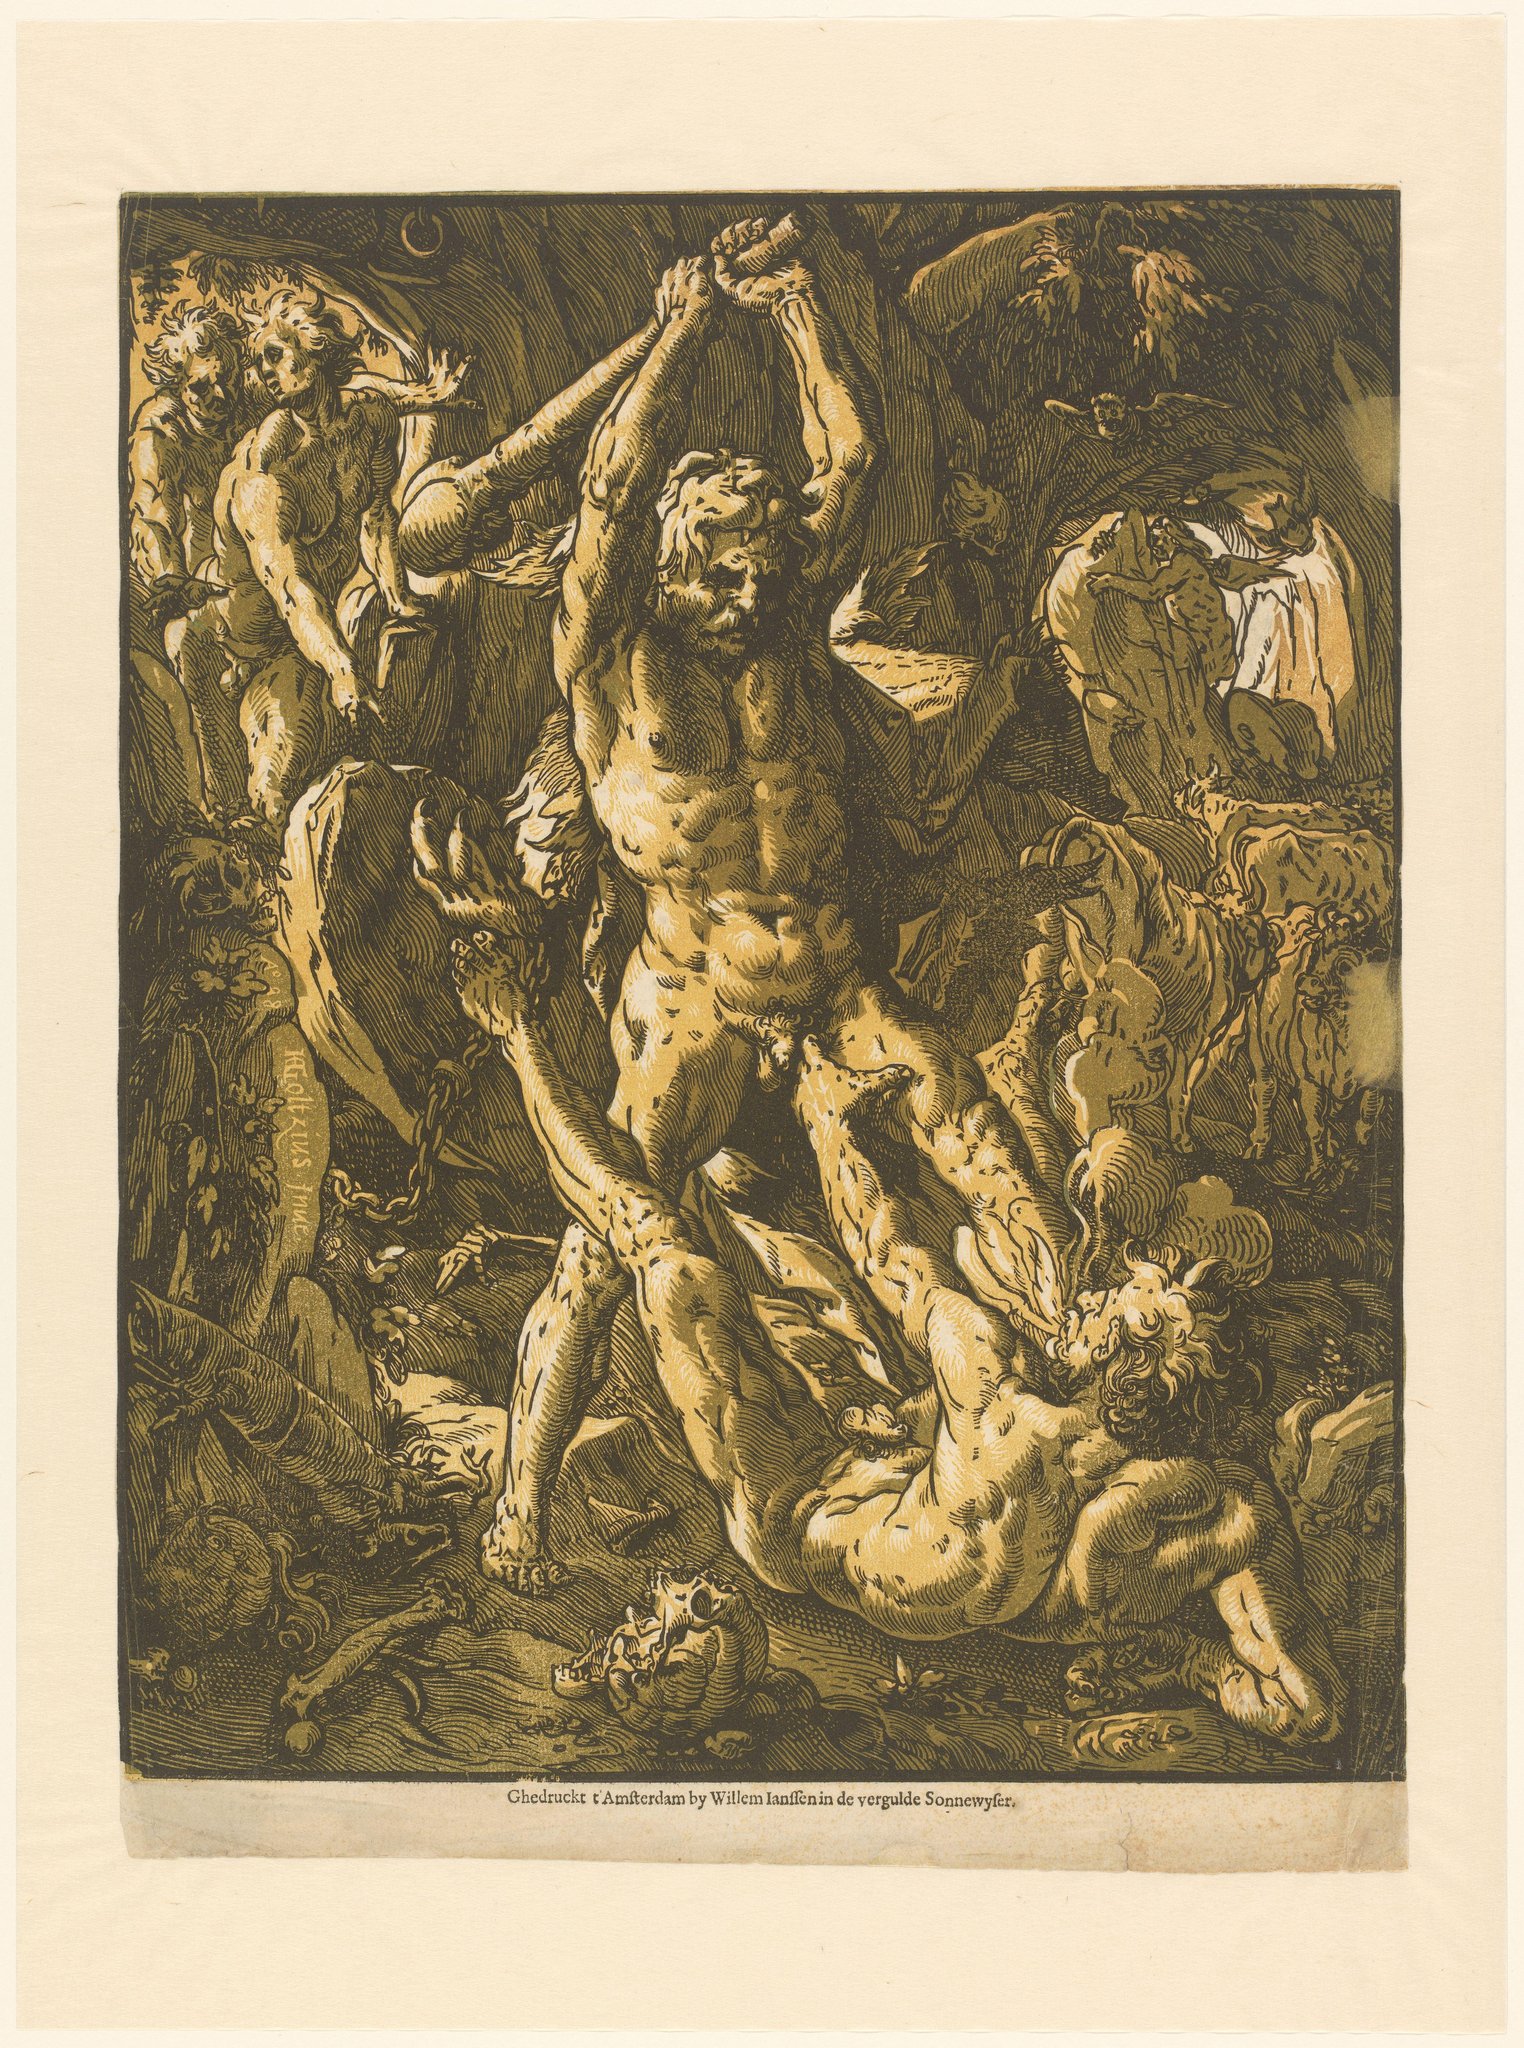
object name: print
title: Hercules en Cacus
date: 1588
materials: paper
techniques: woodcut, letterpress printing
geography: haarlem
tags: cacus, the fire-breathing monster is killed in his cave by hercules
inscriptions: collector's mark: Lugt 2228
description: Hercules heft een grote knots op om Cacus, op de grond liggend in zijn grot, te slaan.